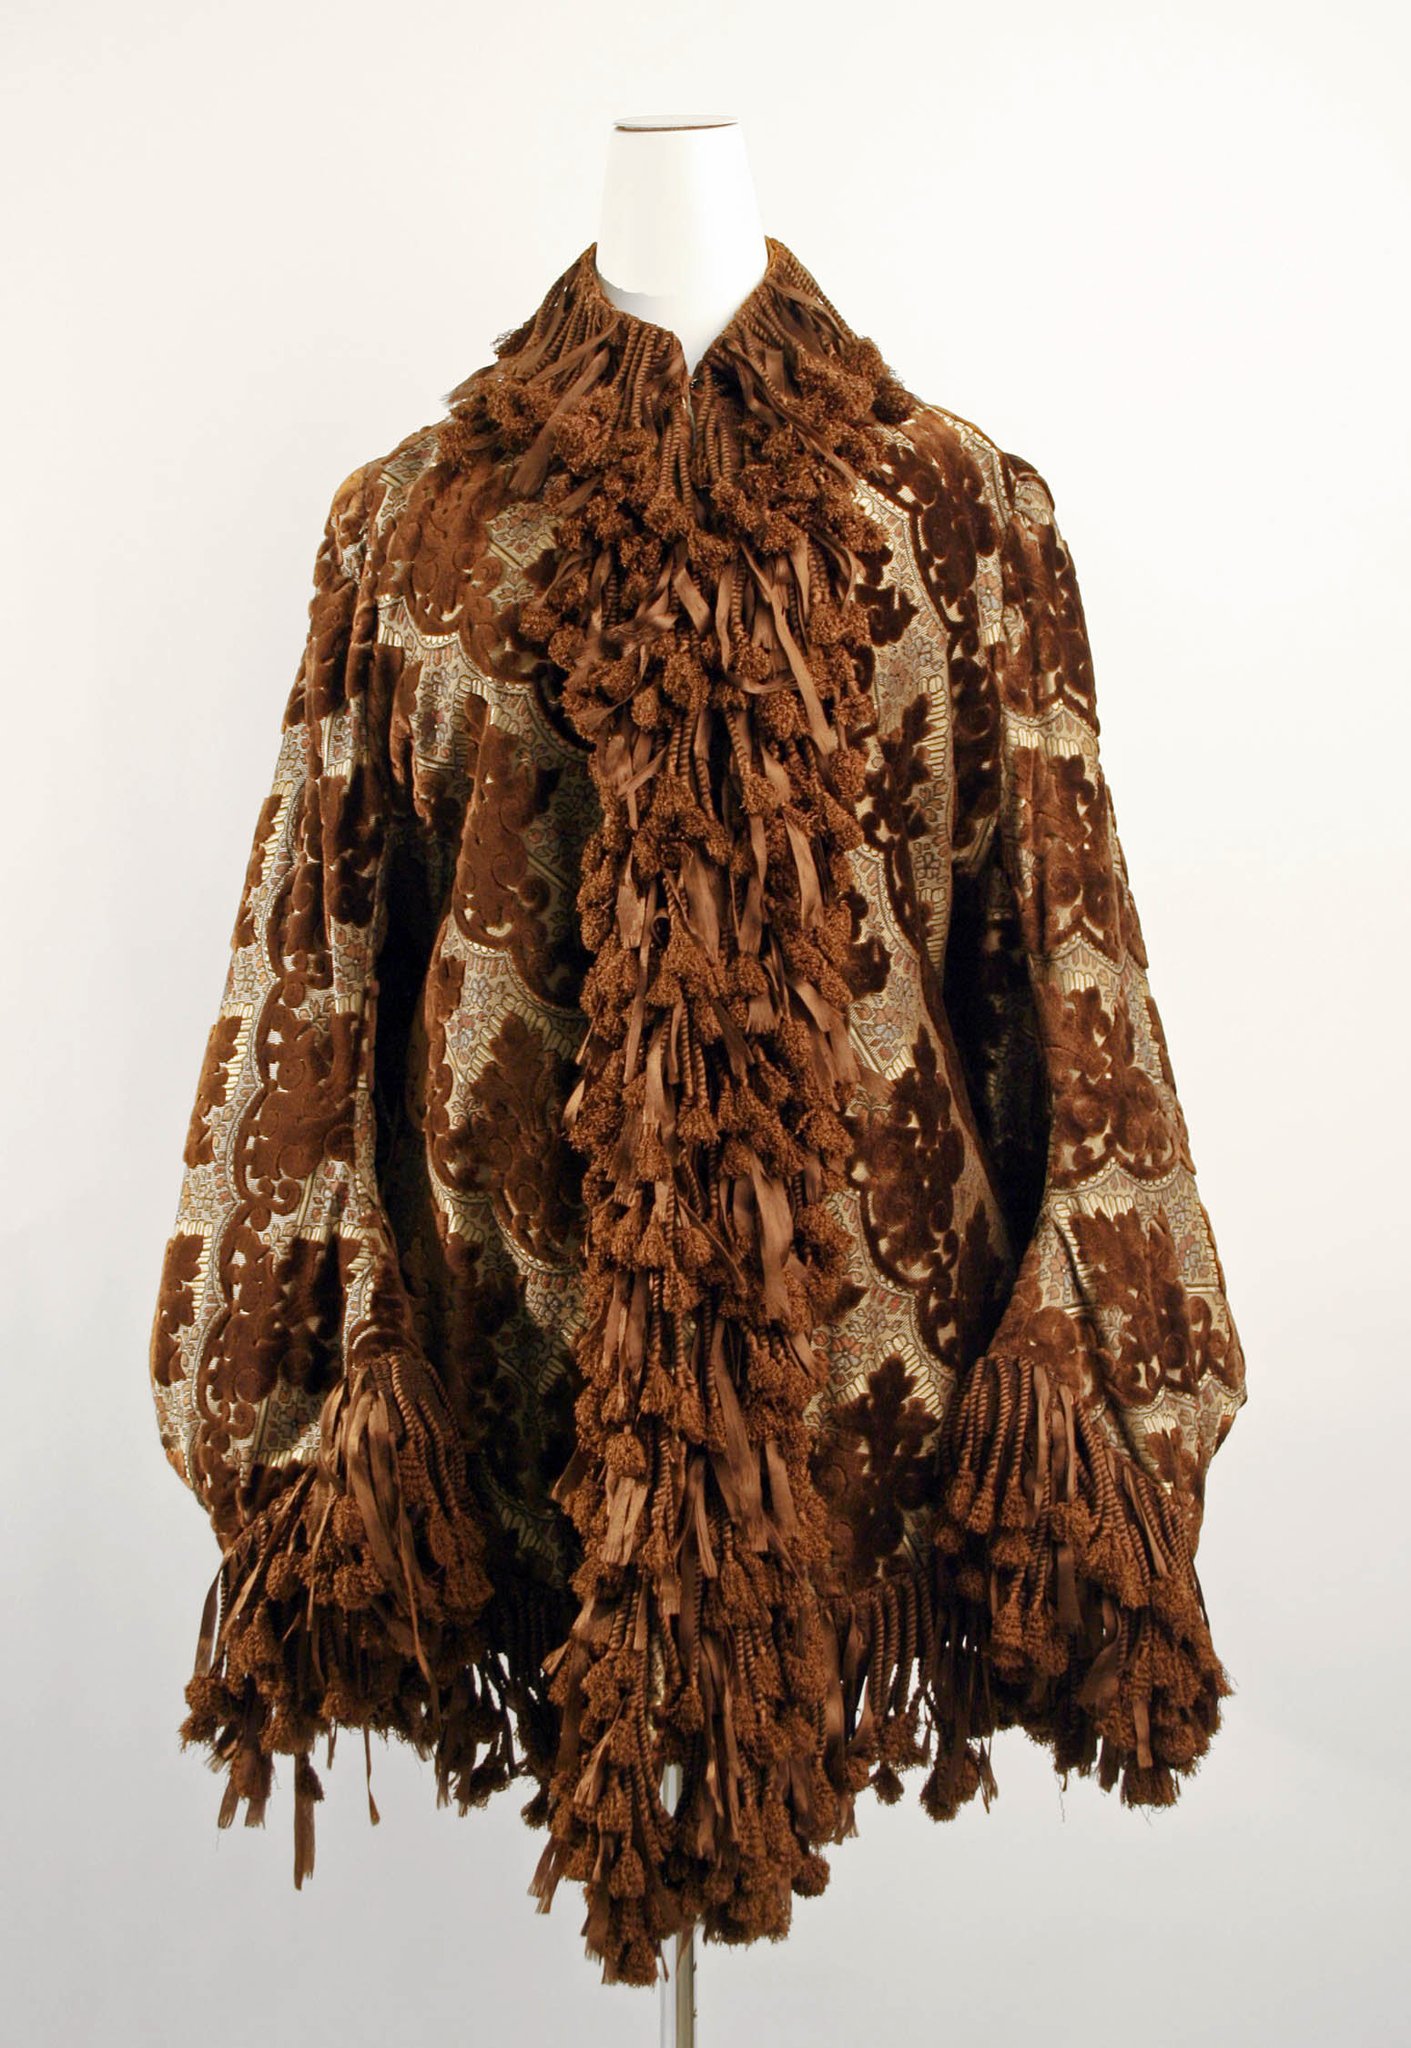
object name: dolman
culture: american or european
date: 1883-1889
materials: silk